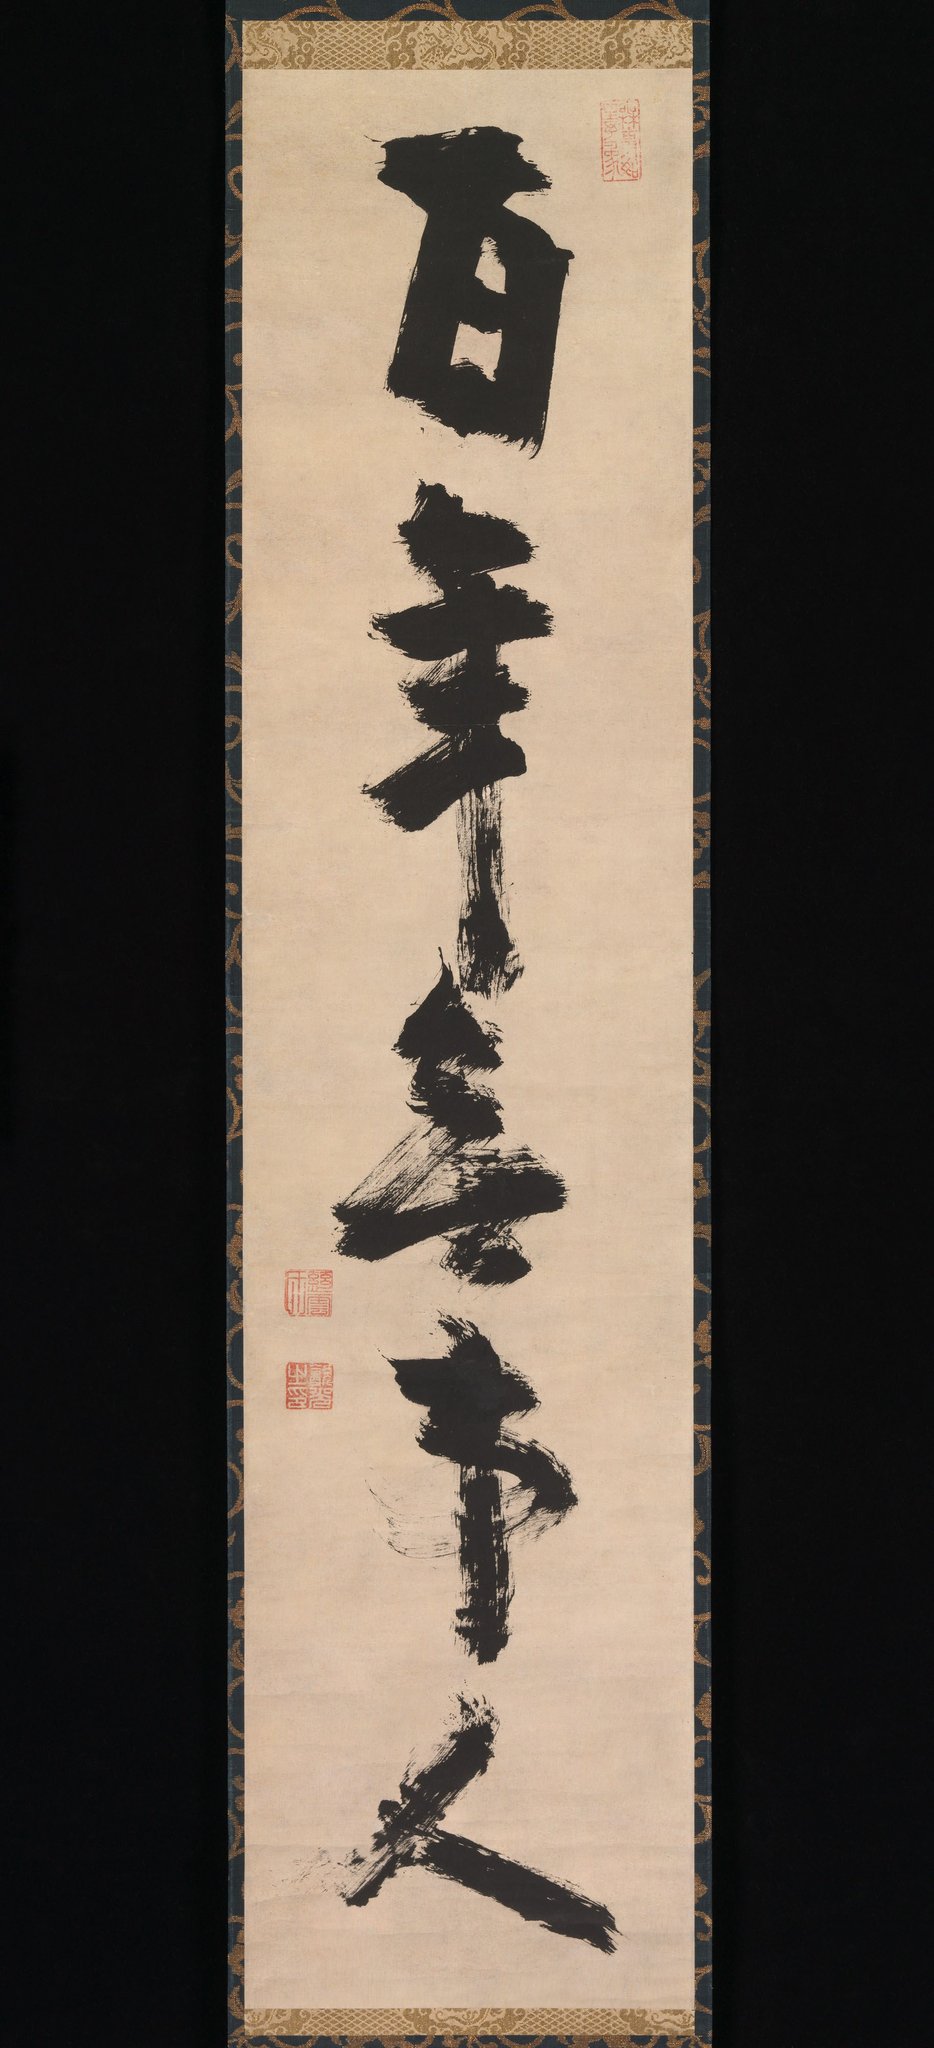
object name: hanging scroll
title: For a hundred years [I have been] a person with no attachments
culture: japanese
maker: jiun onkō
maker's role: artist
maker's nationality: japanese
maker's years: 1718-1804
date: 1767-1800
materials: ink, paper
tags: calligraphy